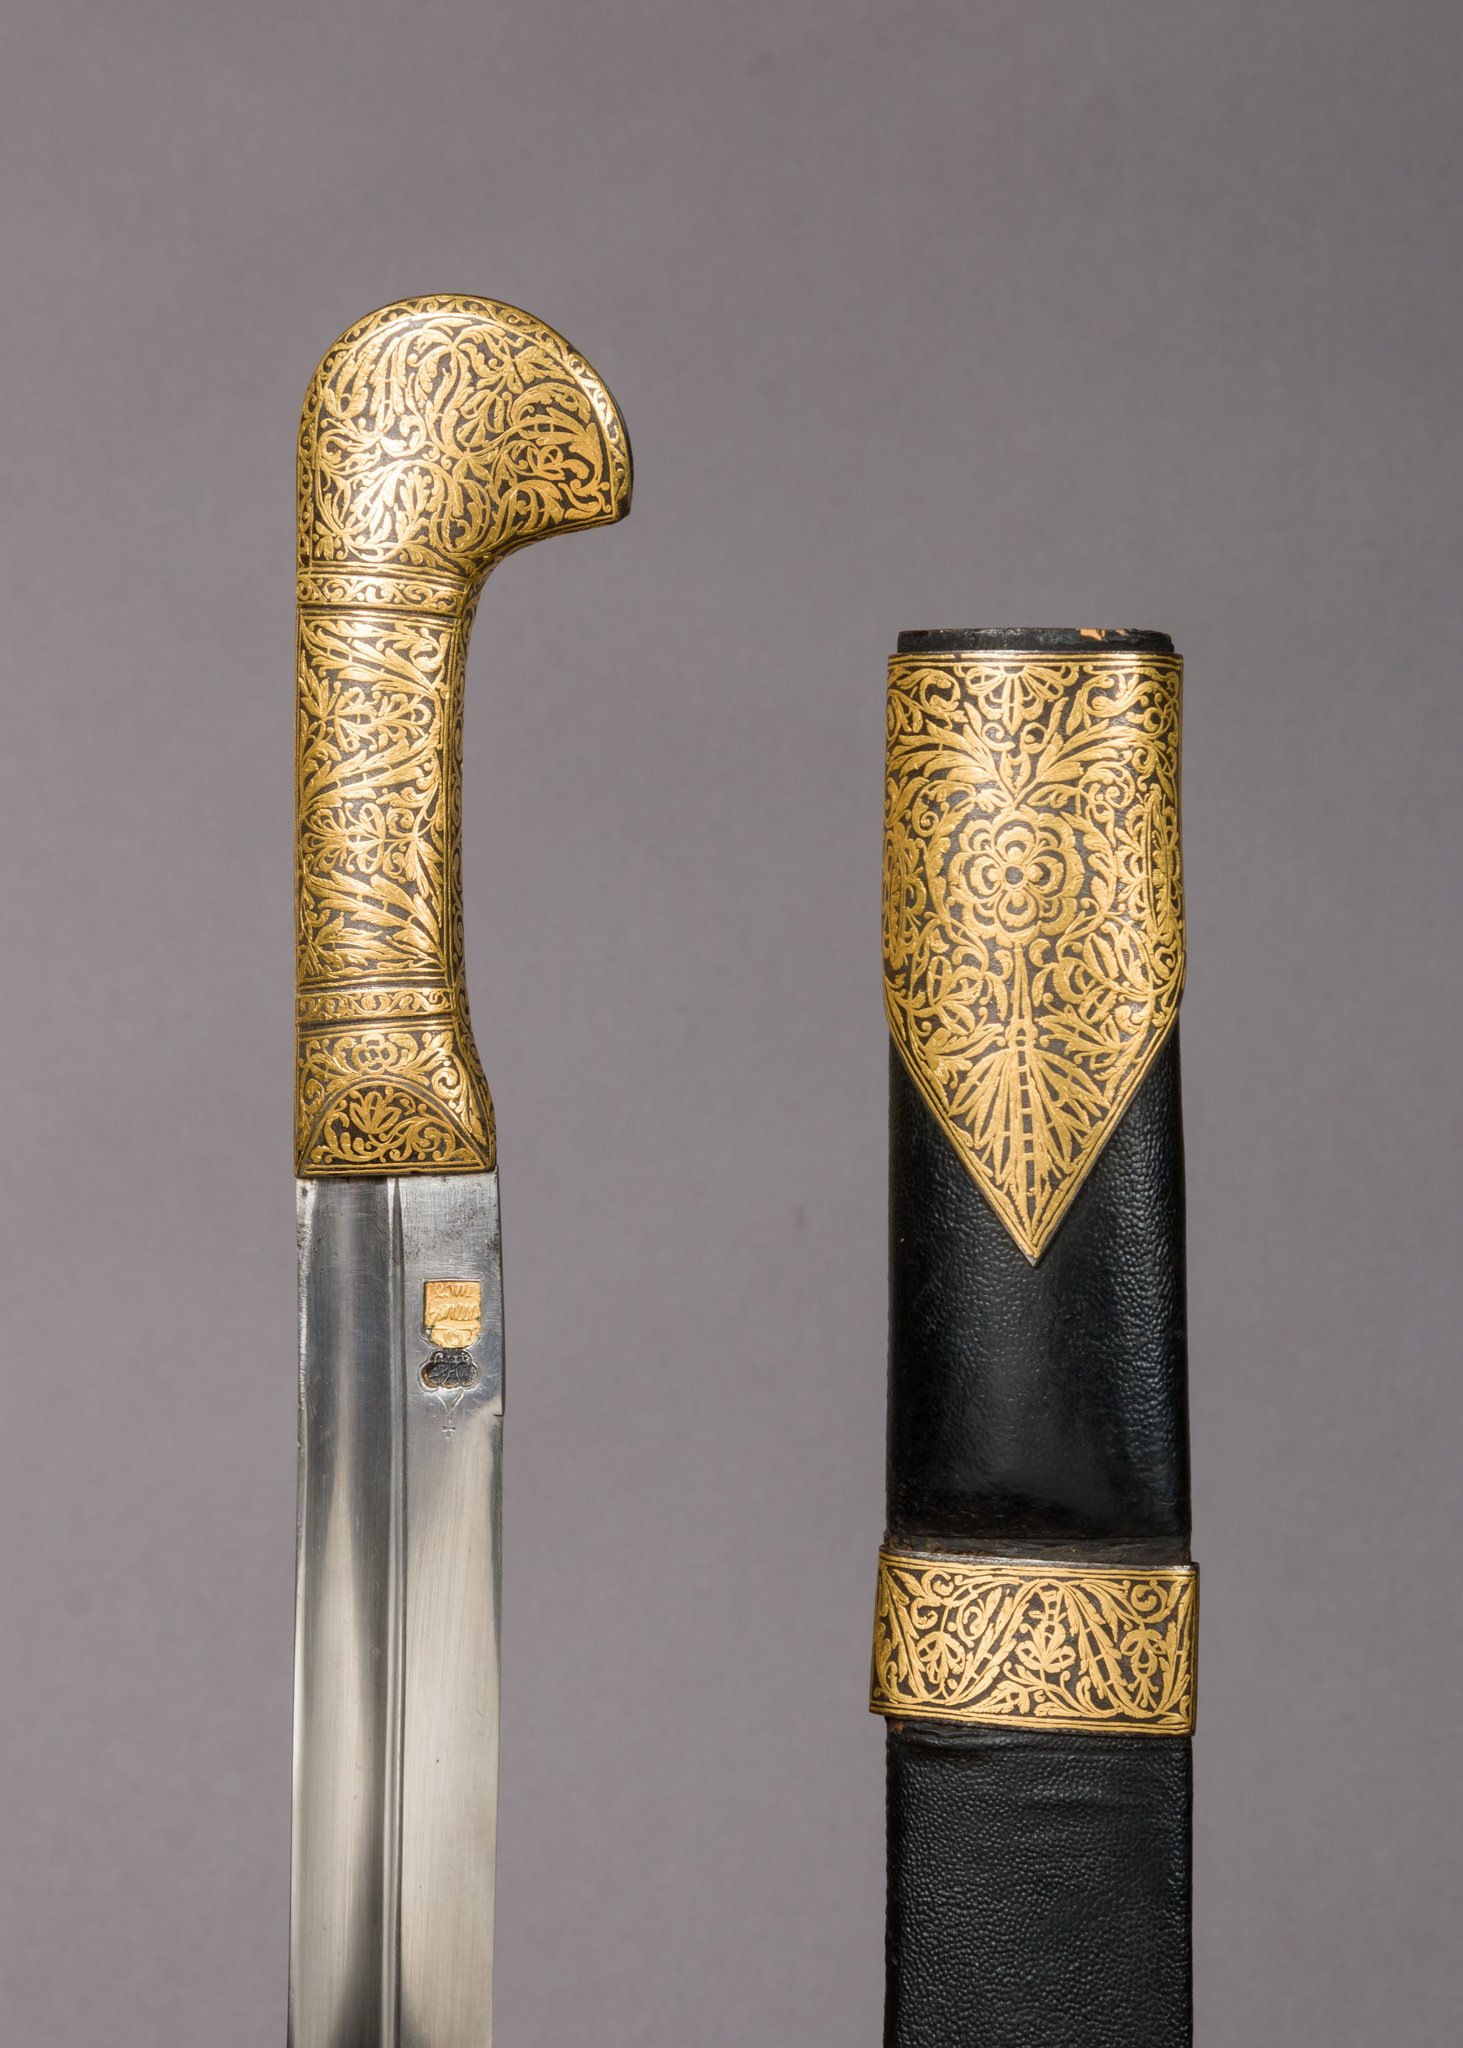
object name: sword and sheath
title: Sword with Sheath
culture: caucasian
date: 1801-1900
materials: gold, leather, steel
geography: caucasus